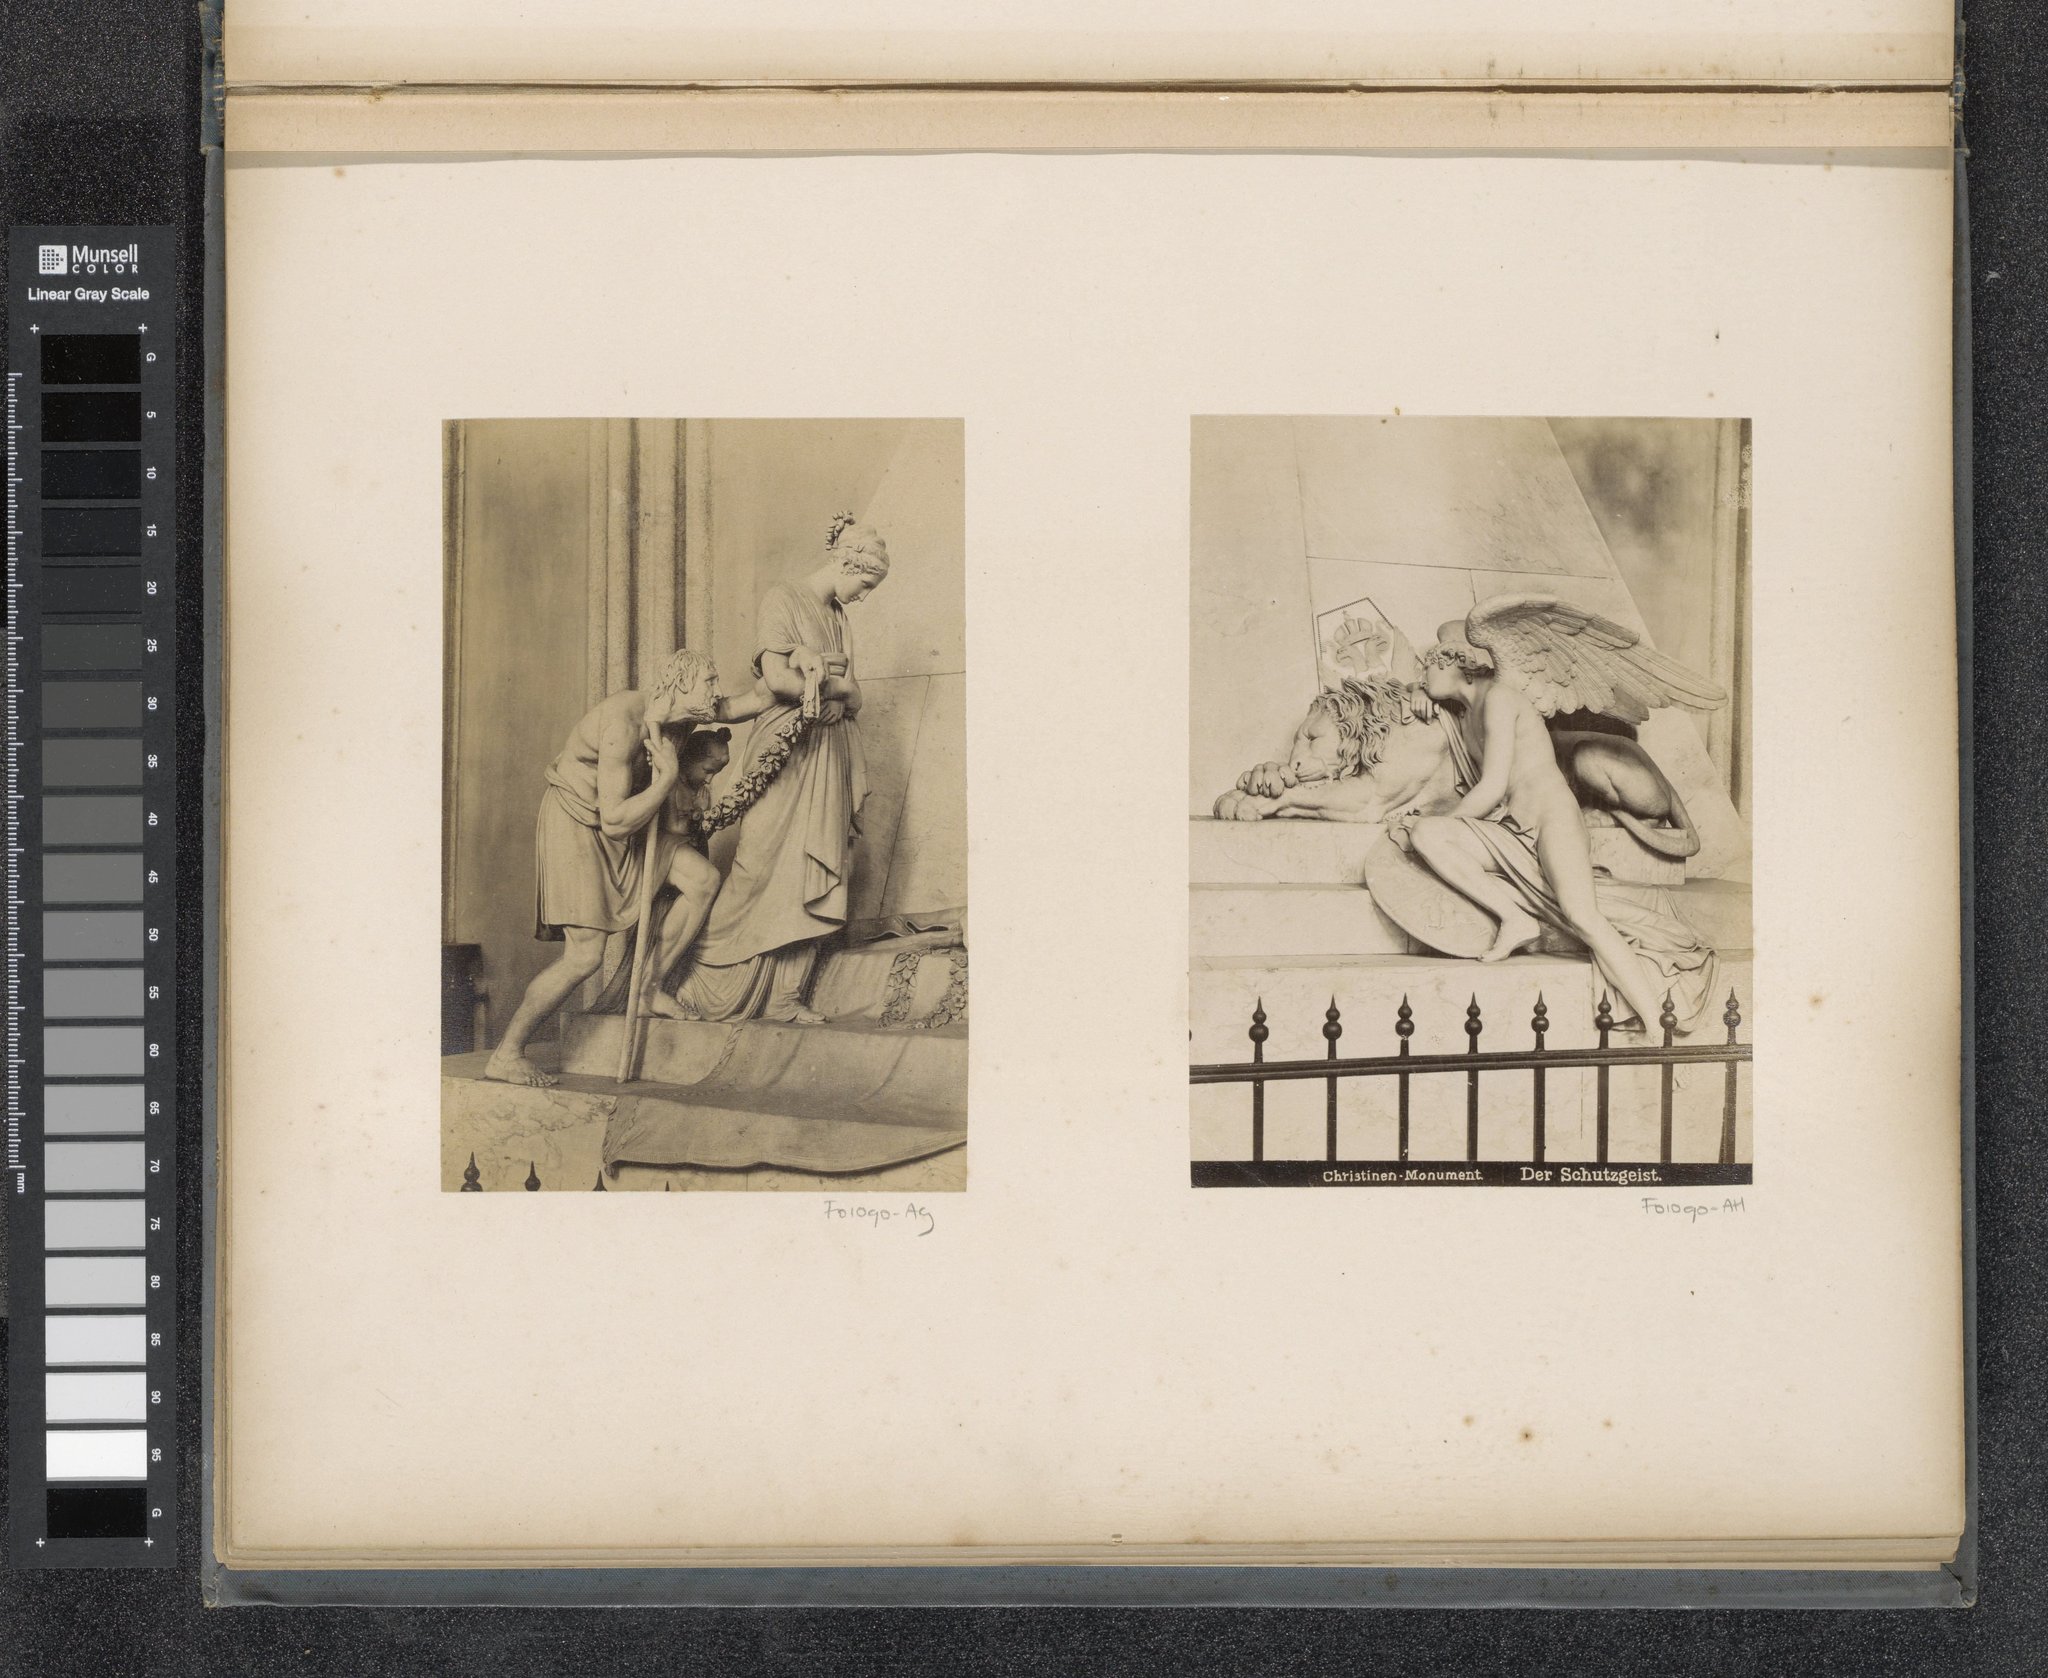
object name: photograph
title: Beelden van het monument voor aartshertogin Marie Christina van Oostenrijk in de Augustijnenkerk in Wenen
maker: Anonymous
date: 1870-1900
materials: paper, photographic support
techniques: albumen print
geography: vienna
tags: sham-grave, cenotaph, piece of sculpture, reproduction of a piece of sculpture, vienna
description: Onderdeel van Reisalbum met foto's van bezienswaardigheden in Duitsland en Oostenrijk en van kunstwerken.